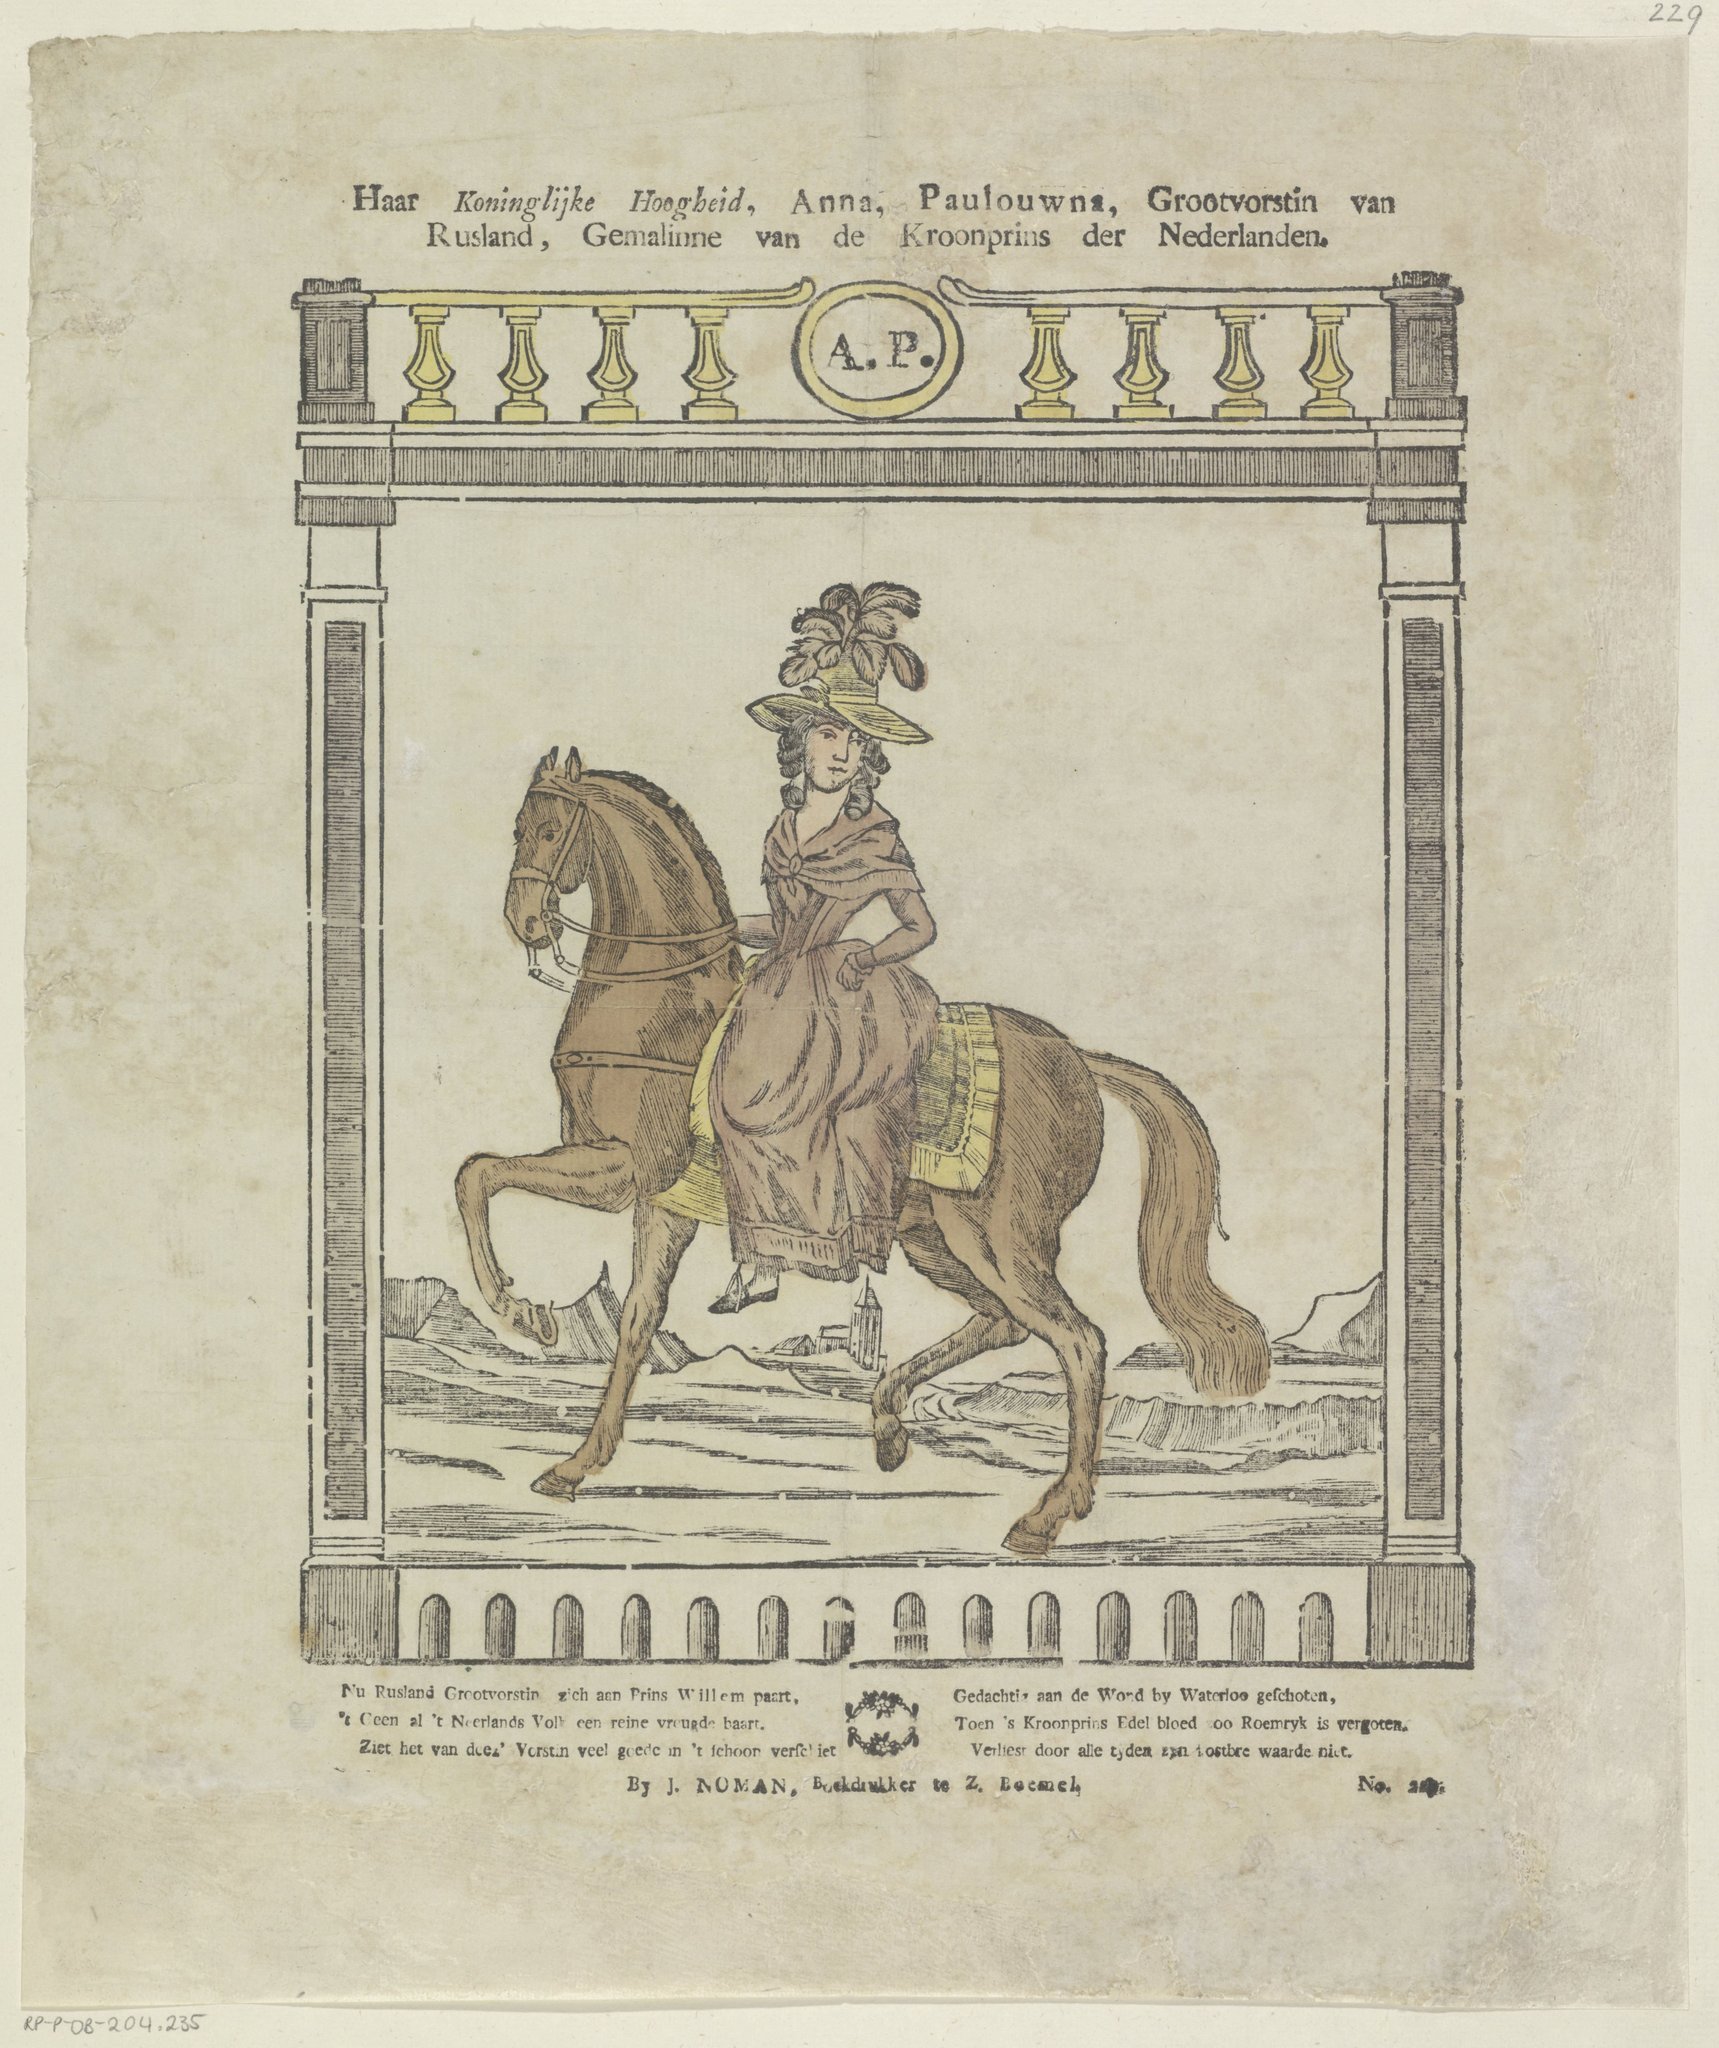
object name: popular print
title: Haar Koninglijke Hoogheid, Anna, Paulowna, Grootvorstin van / Rusland, Gemalinne van de Kroonprins der Nederlanden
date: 1806-1830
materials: paper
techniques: colour, letterpress printing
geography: netherlands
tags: anna paulowna romanowa, joséphine de beauharnais, equestrian state-portrait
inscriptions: collector's mark: Lugt 2760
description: Portret van Josephine (keizerin der Fransen) te paard, hier als Anna Paulowna Romanowa bedoeld. De voorstelling is gevat in een sierlijst, met aan de bovenzijde een balustrade. Onder de afbeelding een vers in twee kolommen. Genummerd rechtsonder: No. 229.